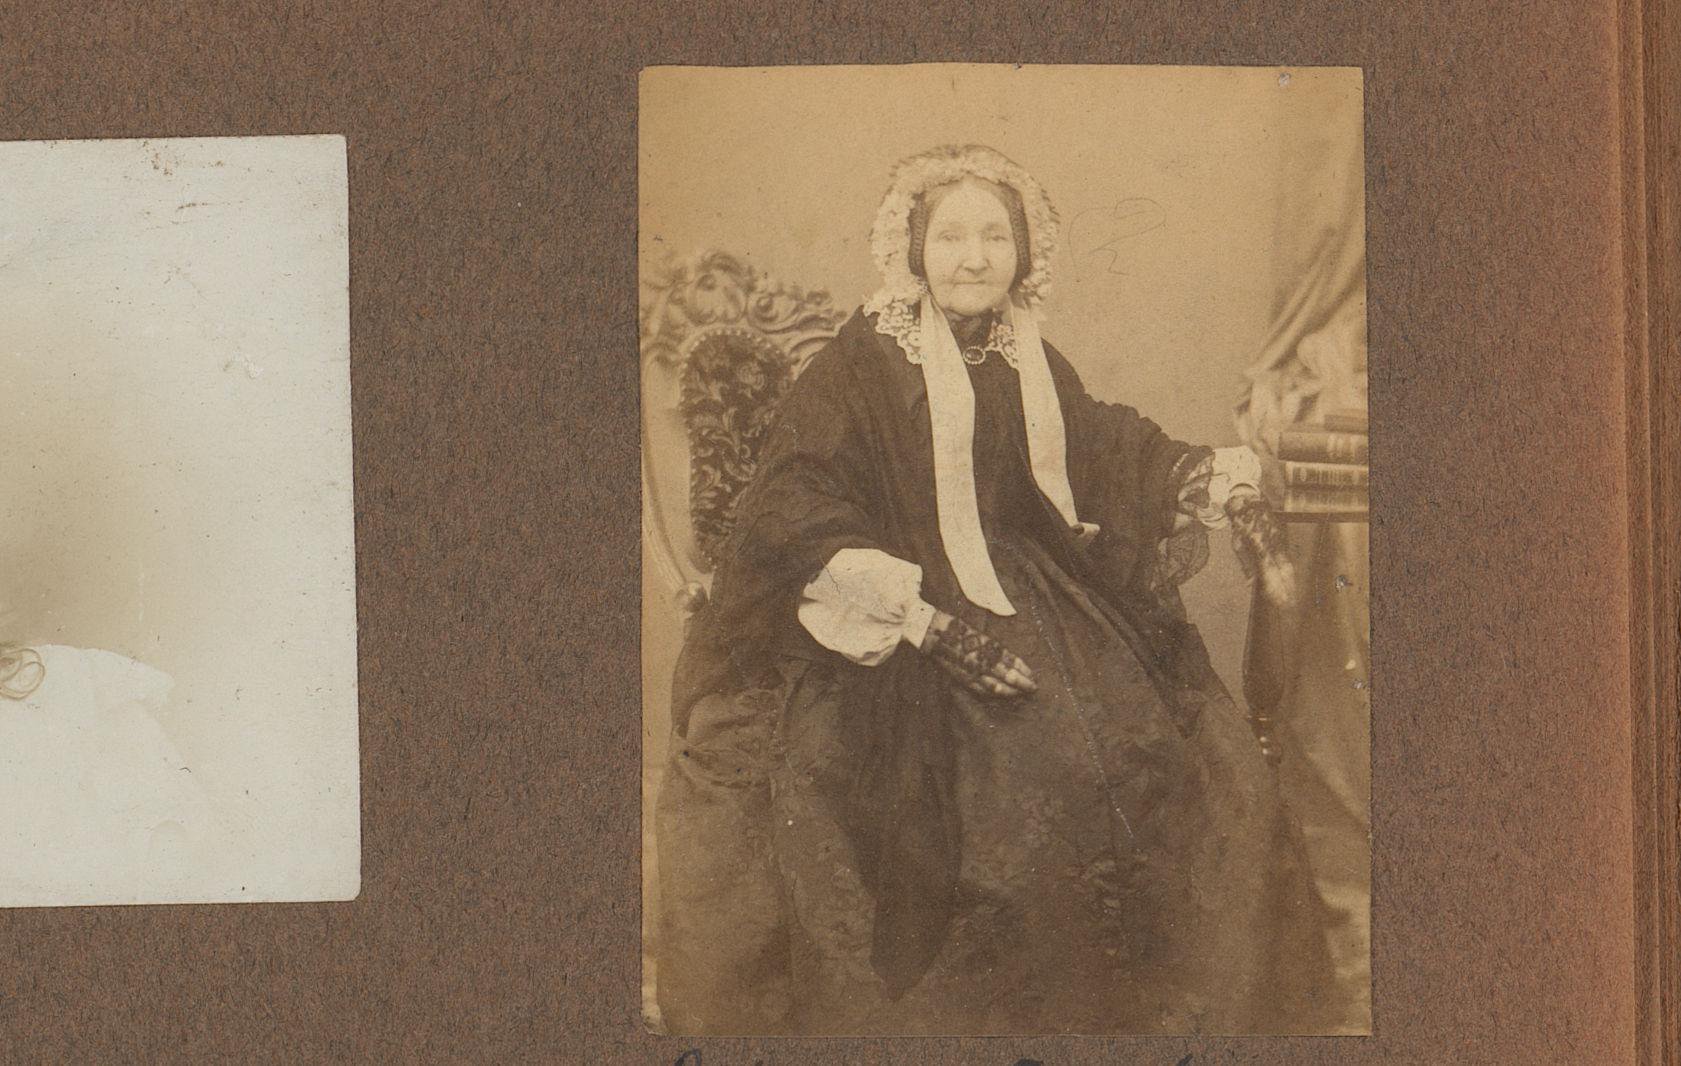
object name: photograph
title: Betovergrootmoeder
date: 1870-1920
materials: photographic support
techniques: photography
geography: netherlands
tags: netherlands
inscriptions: inscription: ‘Betovergrootmoeder / d'....’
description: Foto op bruin albumblad 37 van familiealbum van Alphons Diepenbrock.